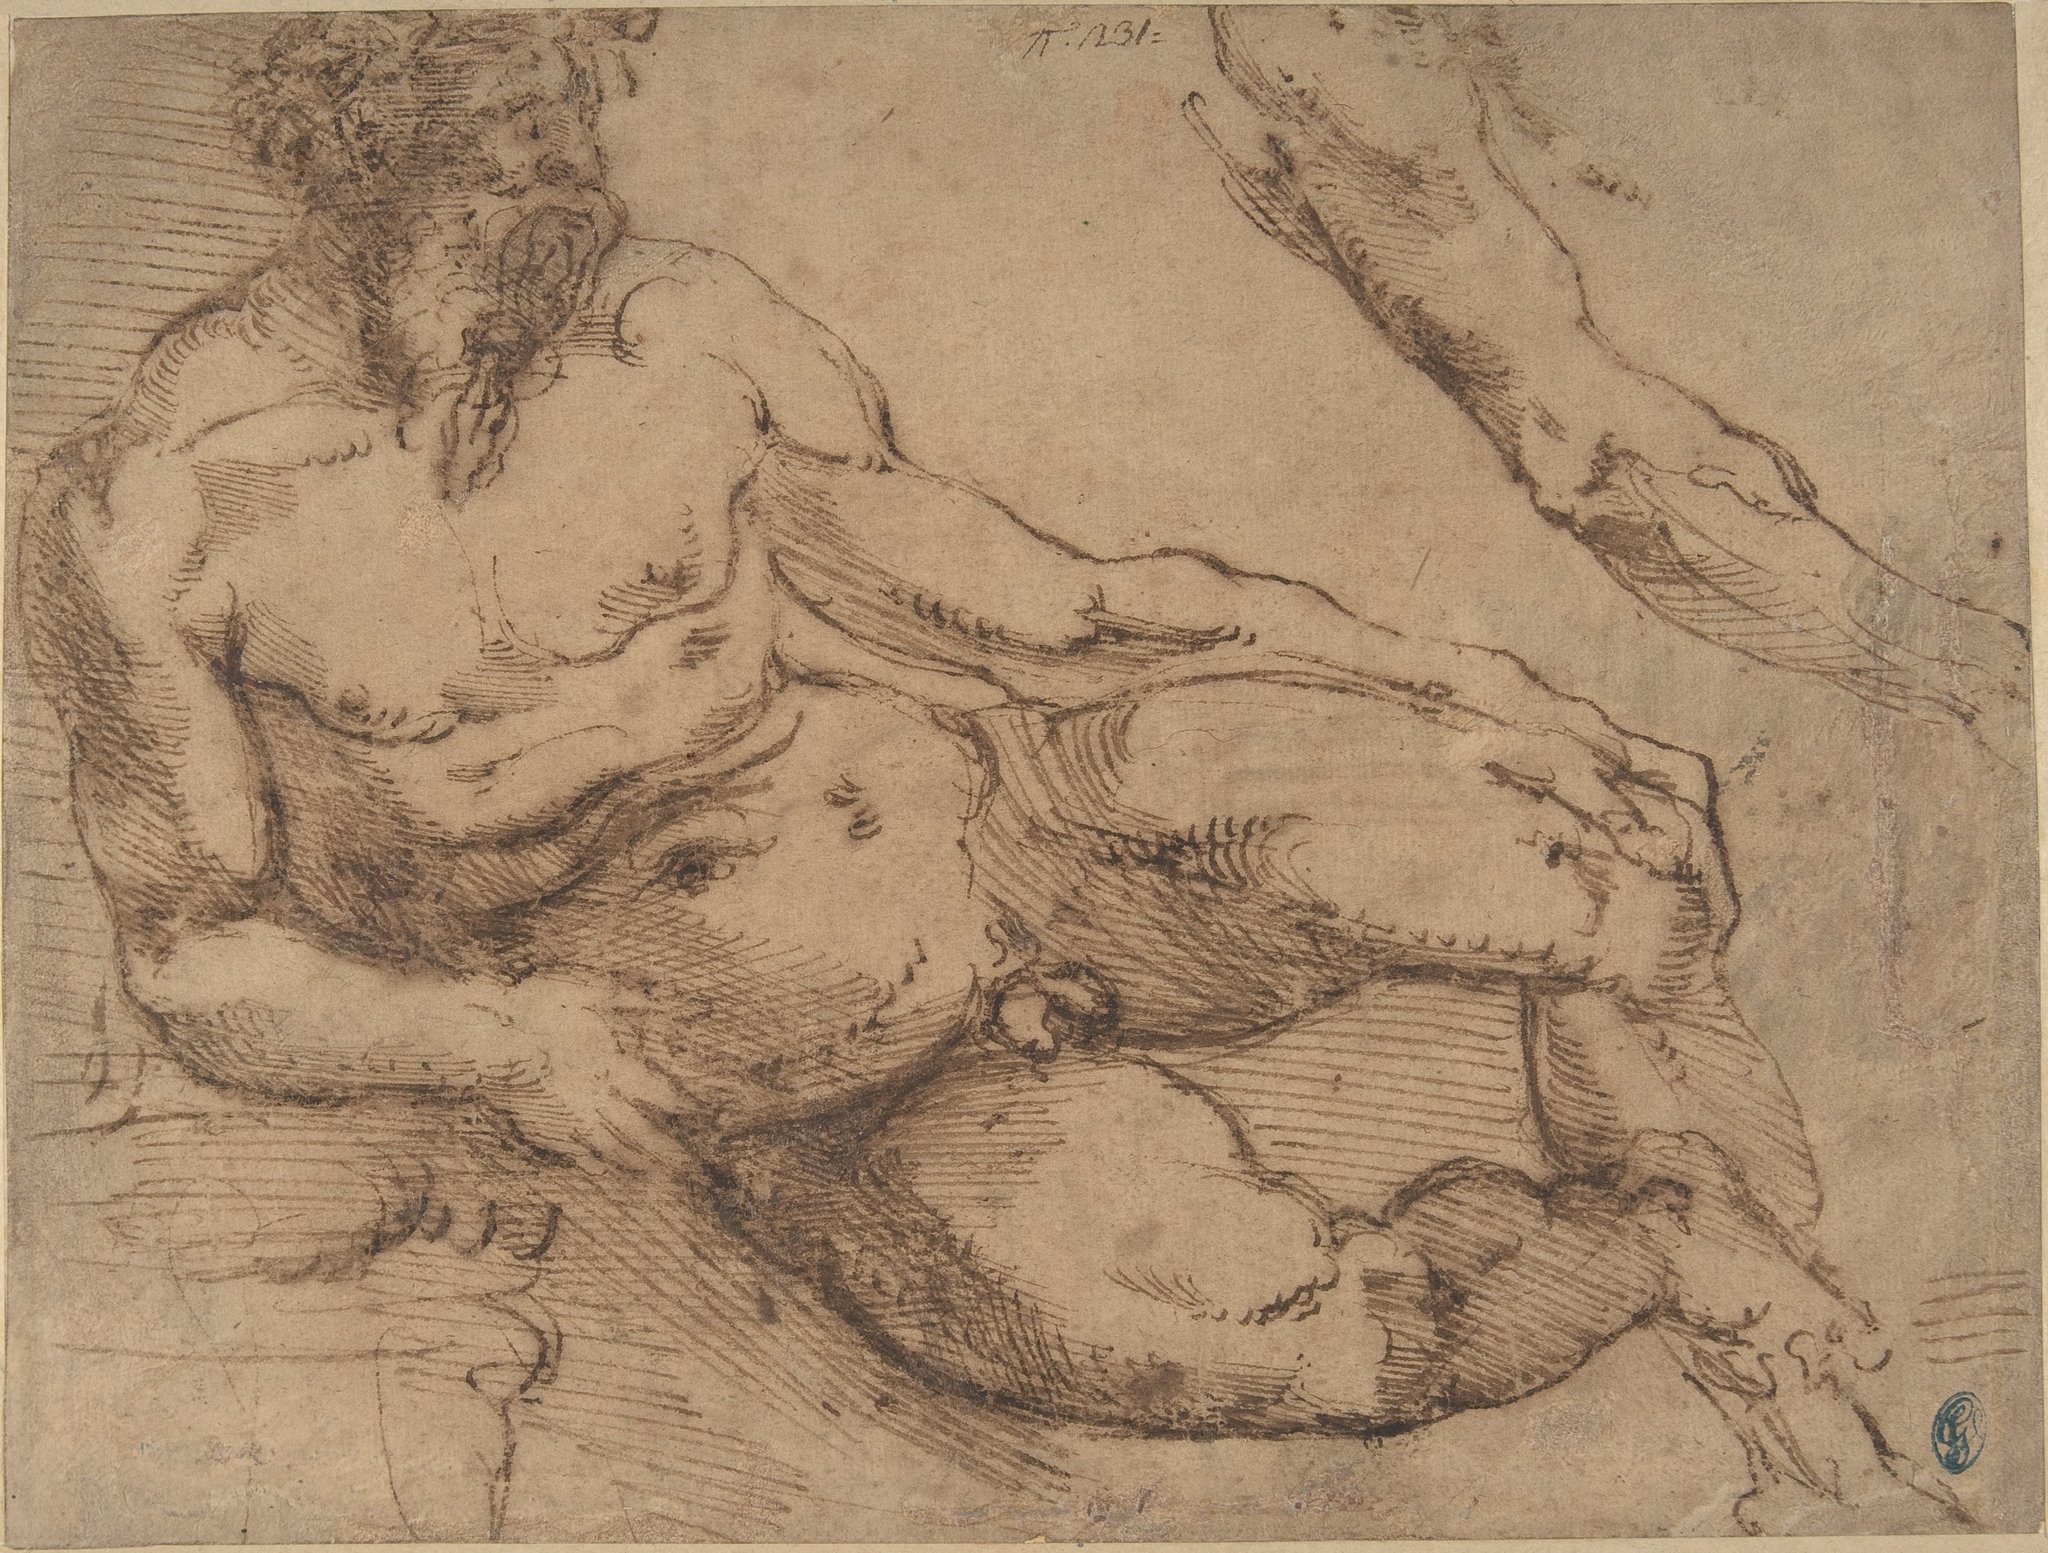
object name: drawing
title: A River God (recto); Sketches for the Vestibule of the Laurenziana, Florence (verso)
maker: bartolomeo ammanati (ammannati)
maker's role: artist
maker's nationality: italian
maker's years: 1511-1592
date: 1511-1592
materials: chalk, ink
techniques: pen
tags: male nudes,gods